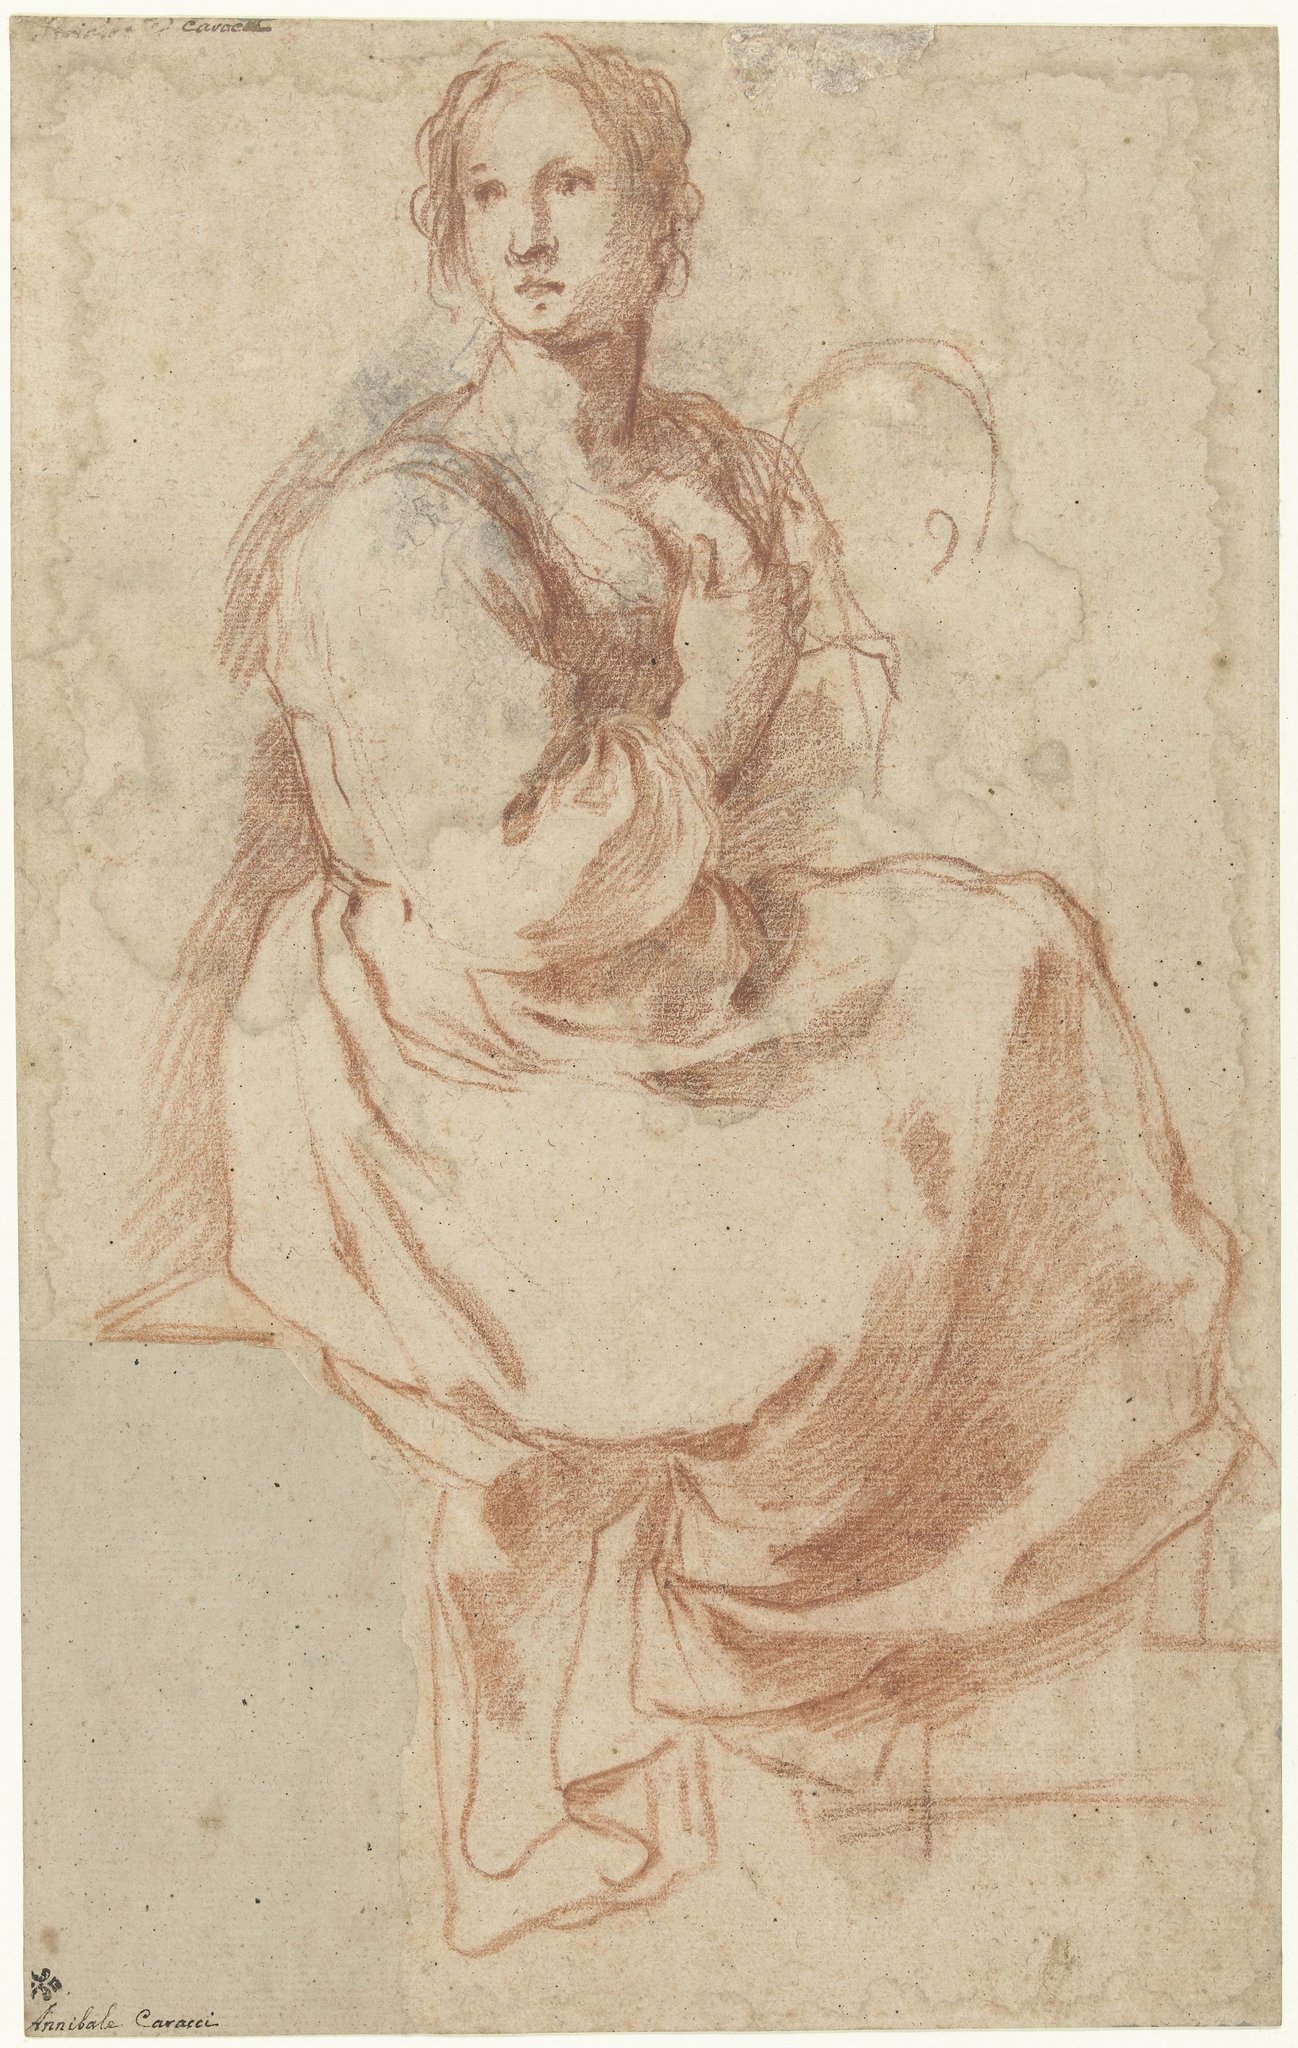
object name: drawing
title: Studie voor Pero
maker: giovanni martinelli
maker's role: draughtsman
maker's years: 1610-1668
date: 1620-1668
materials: chalk, paper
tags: pero suckling cimon ('caritas romana')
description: Studie voor Pero, in een 'Caritas Romana'.